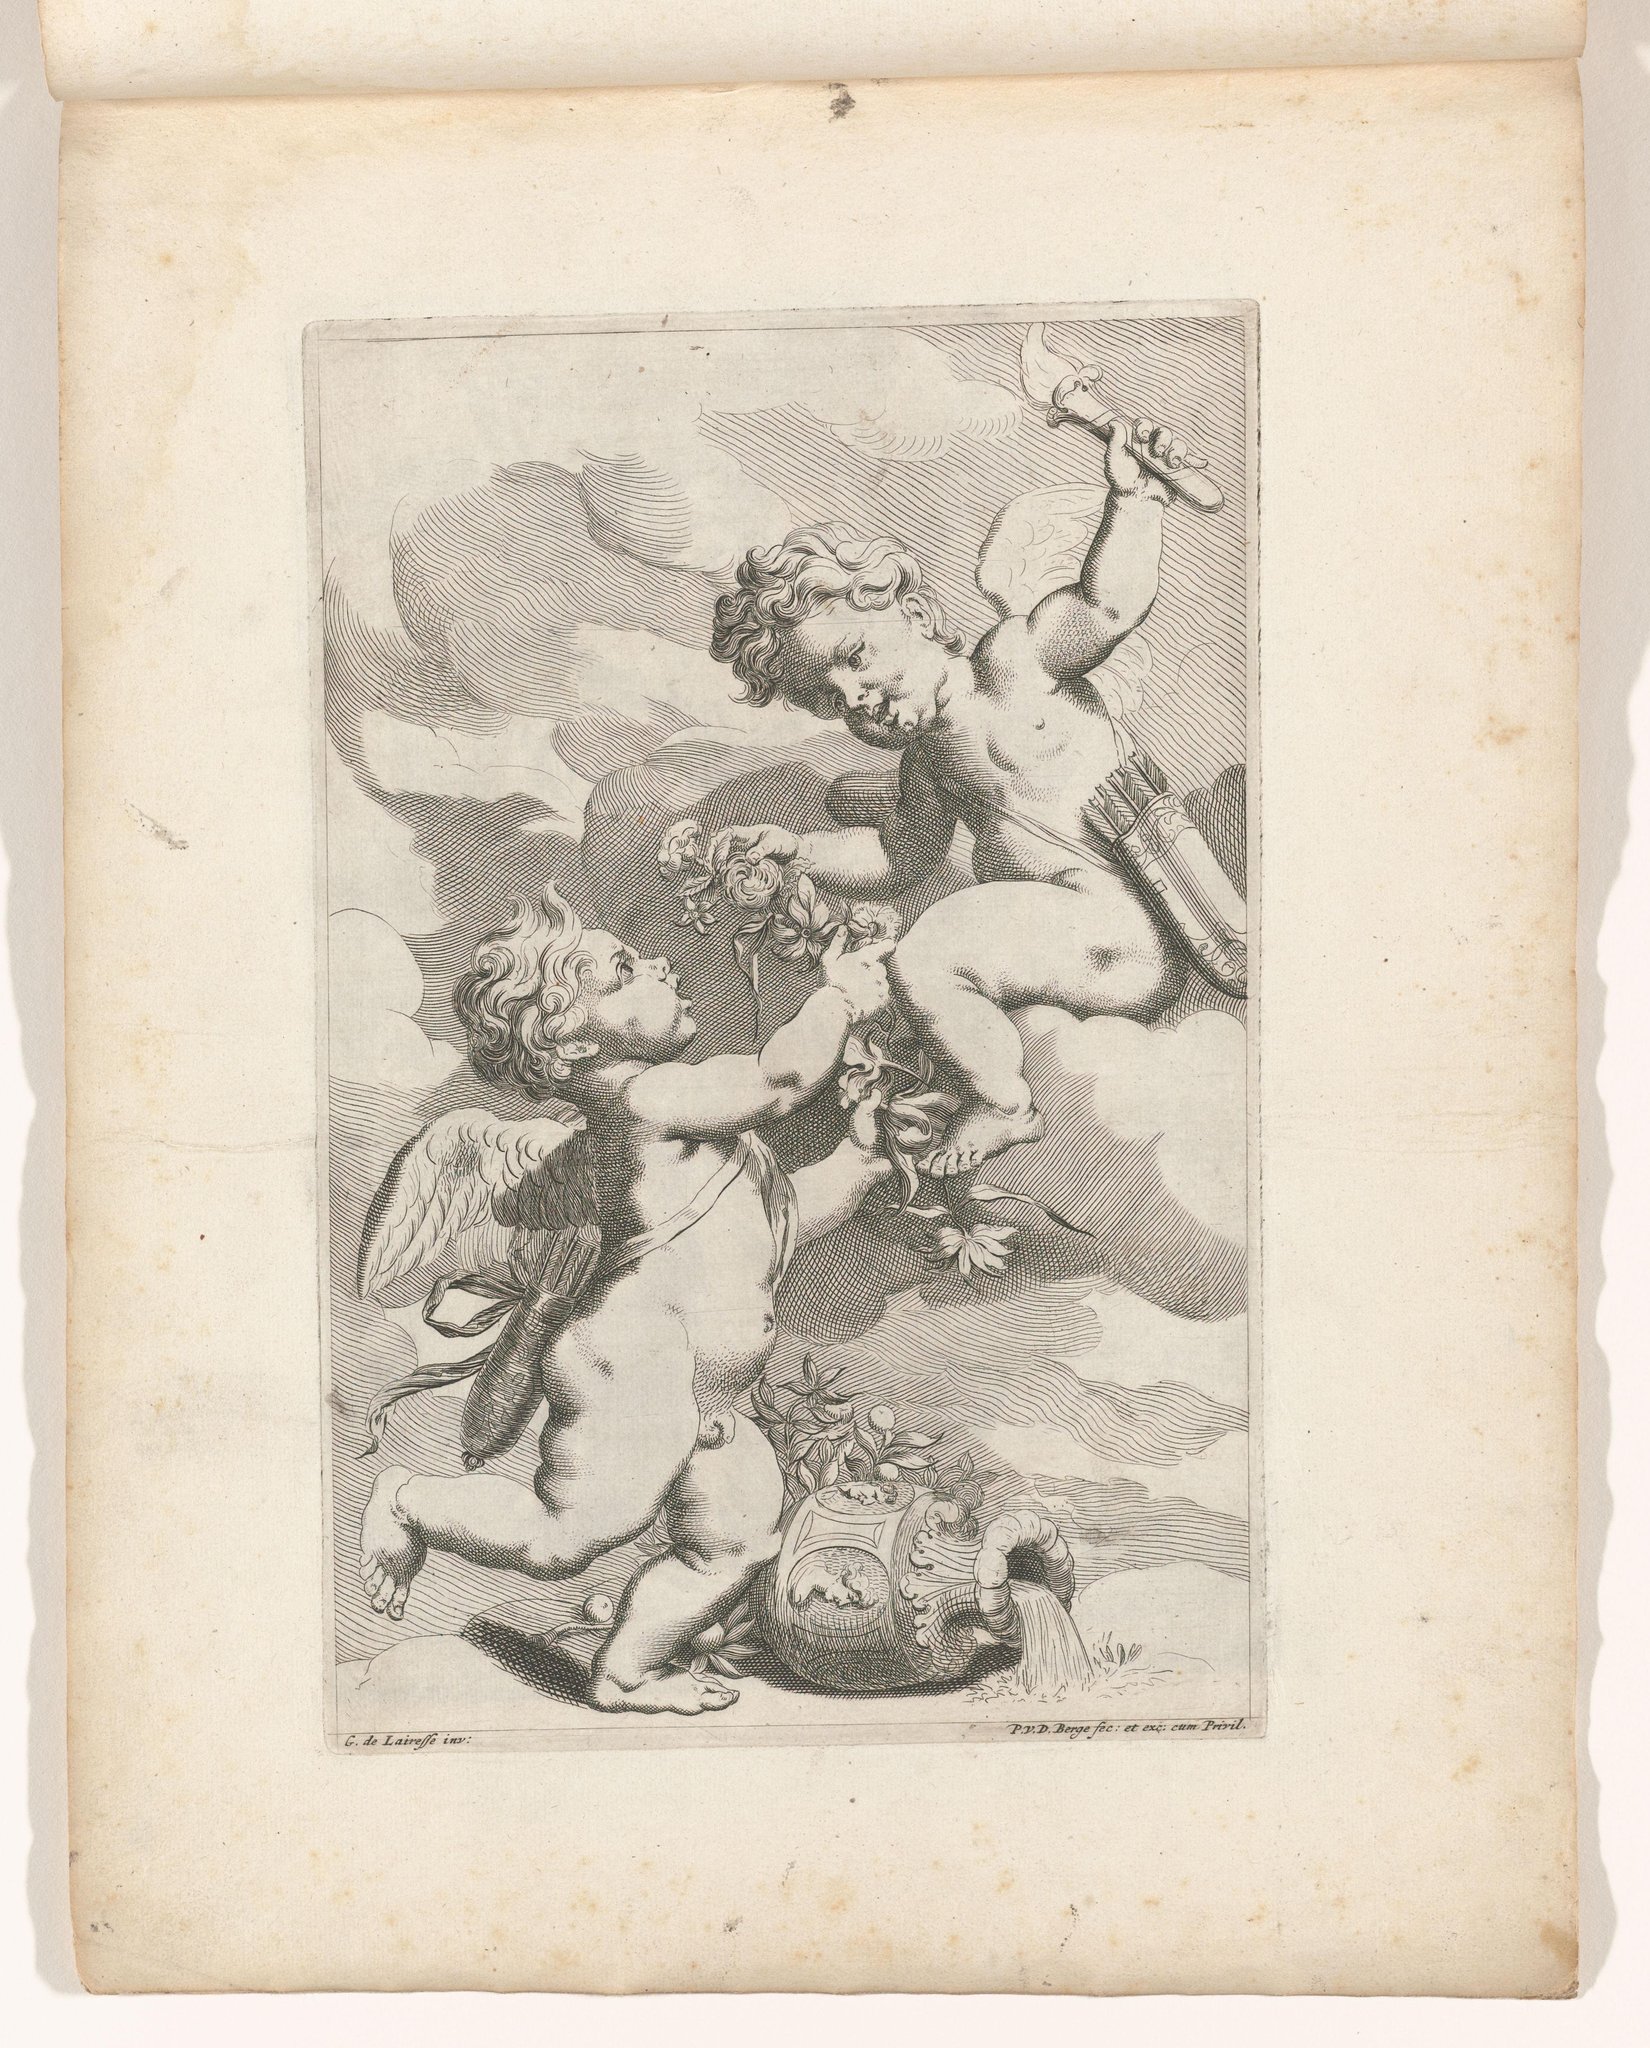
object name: print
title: Prent 7 uit serie tekenvoorbeelden met twee putti met bloemen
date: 1695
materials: paper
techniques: etching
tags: cupids: 'amores', 'amoretti', 'putti'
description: Prentserie van elf bladen met tekenvoorbeelden naar Gerard de Lairesse en een titelblad gebonden in een eigentijds(?) omslag. Elf prenten met voorbeelden van gezichten, mythologische en andere figuren, ornamenten en architectuur.